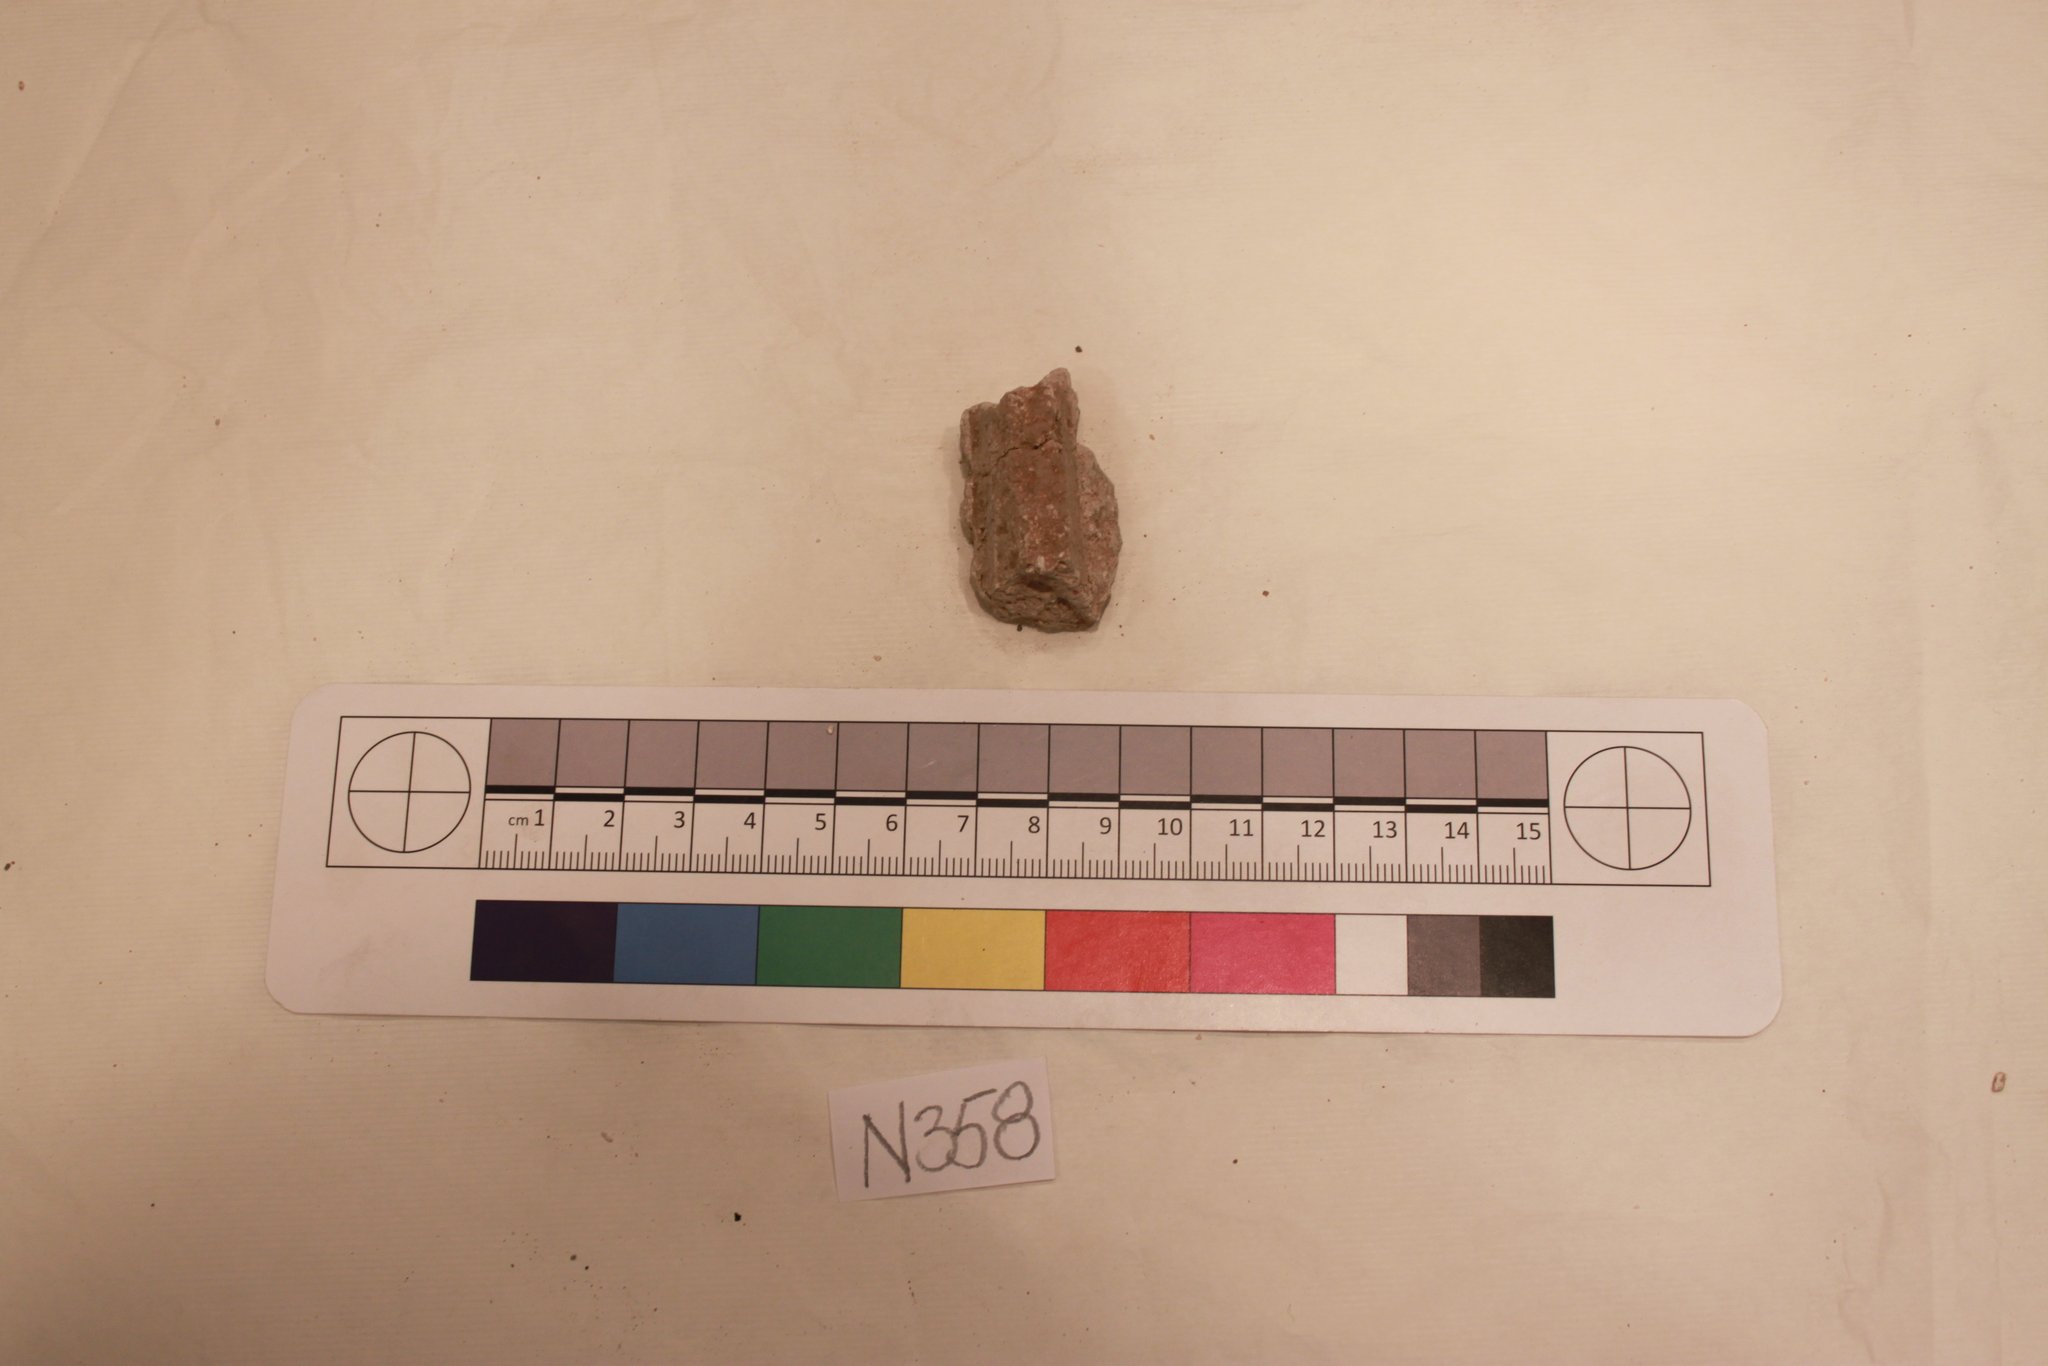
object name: fragment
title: Stucco Fragment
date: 701-1200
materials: plaster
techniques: carving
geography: iran